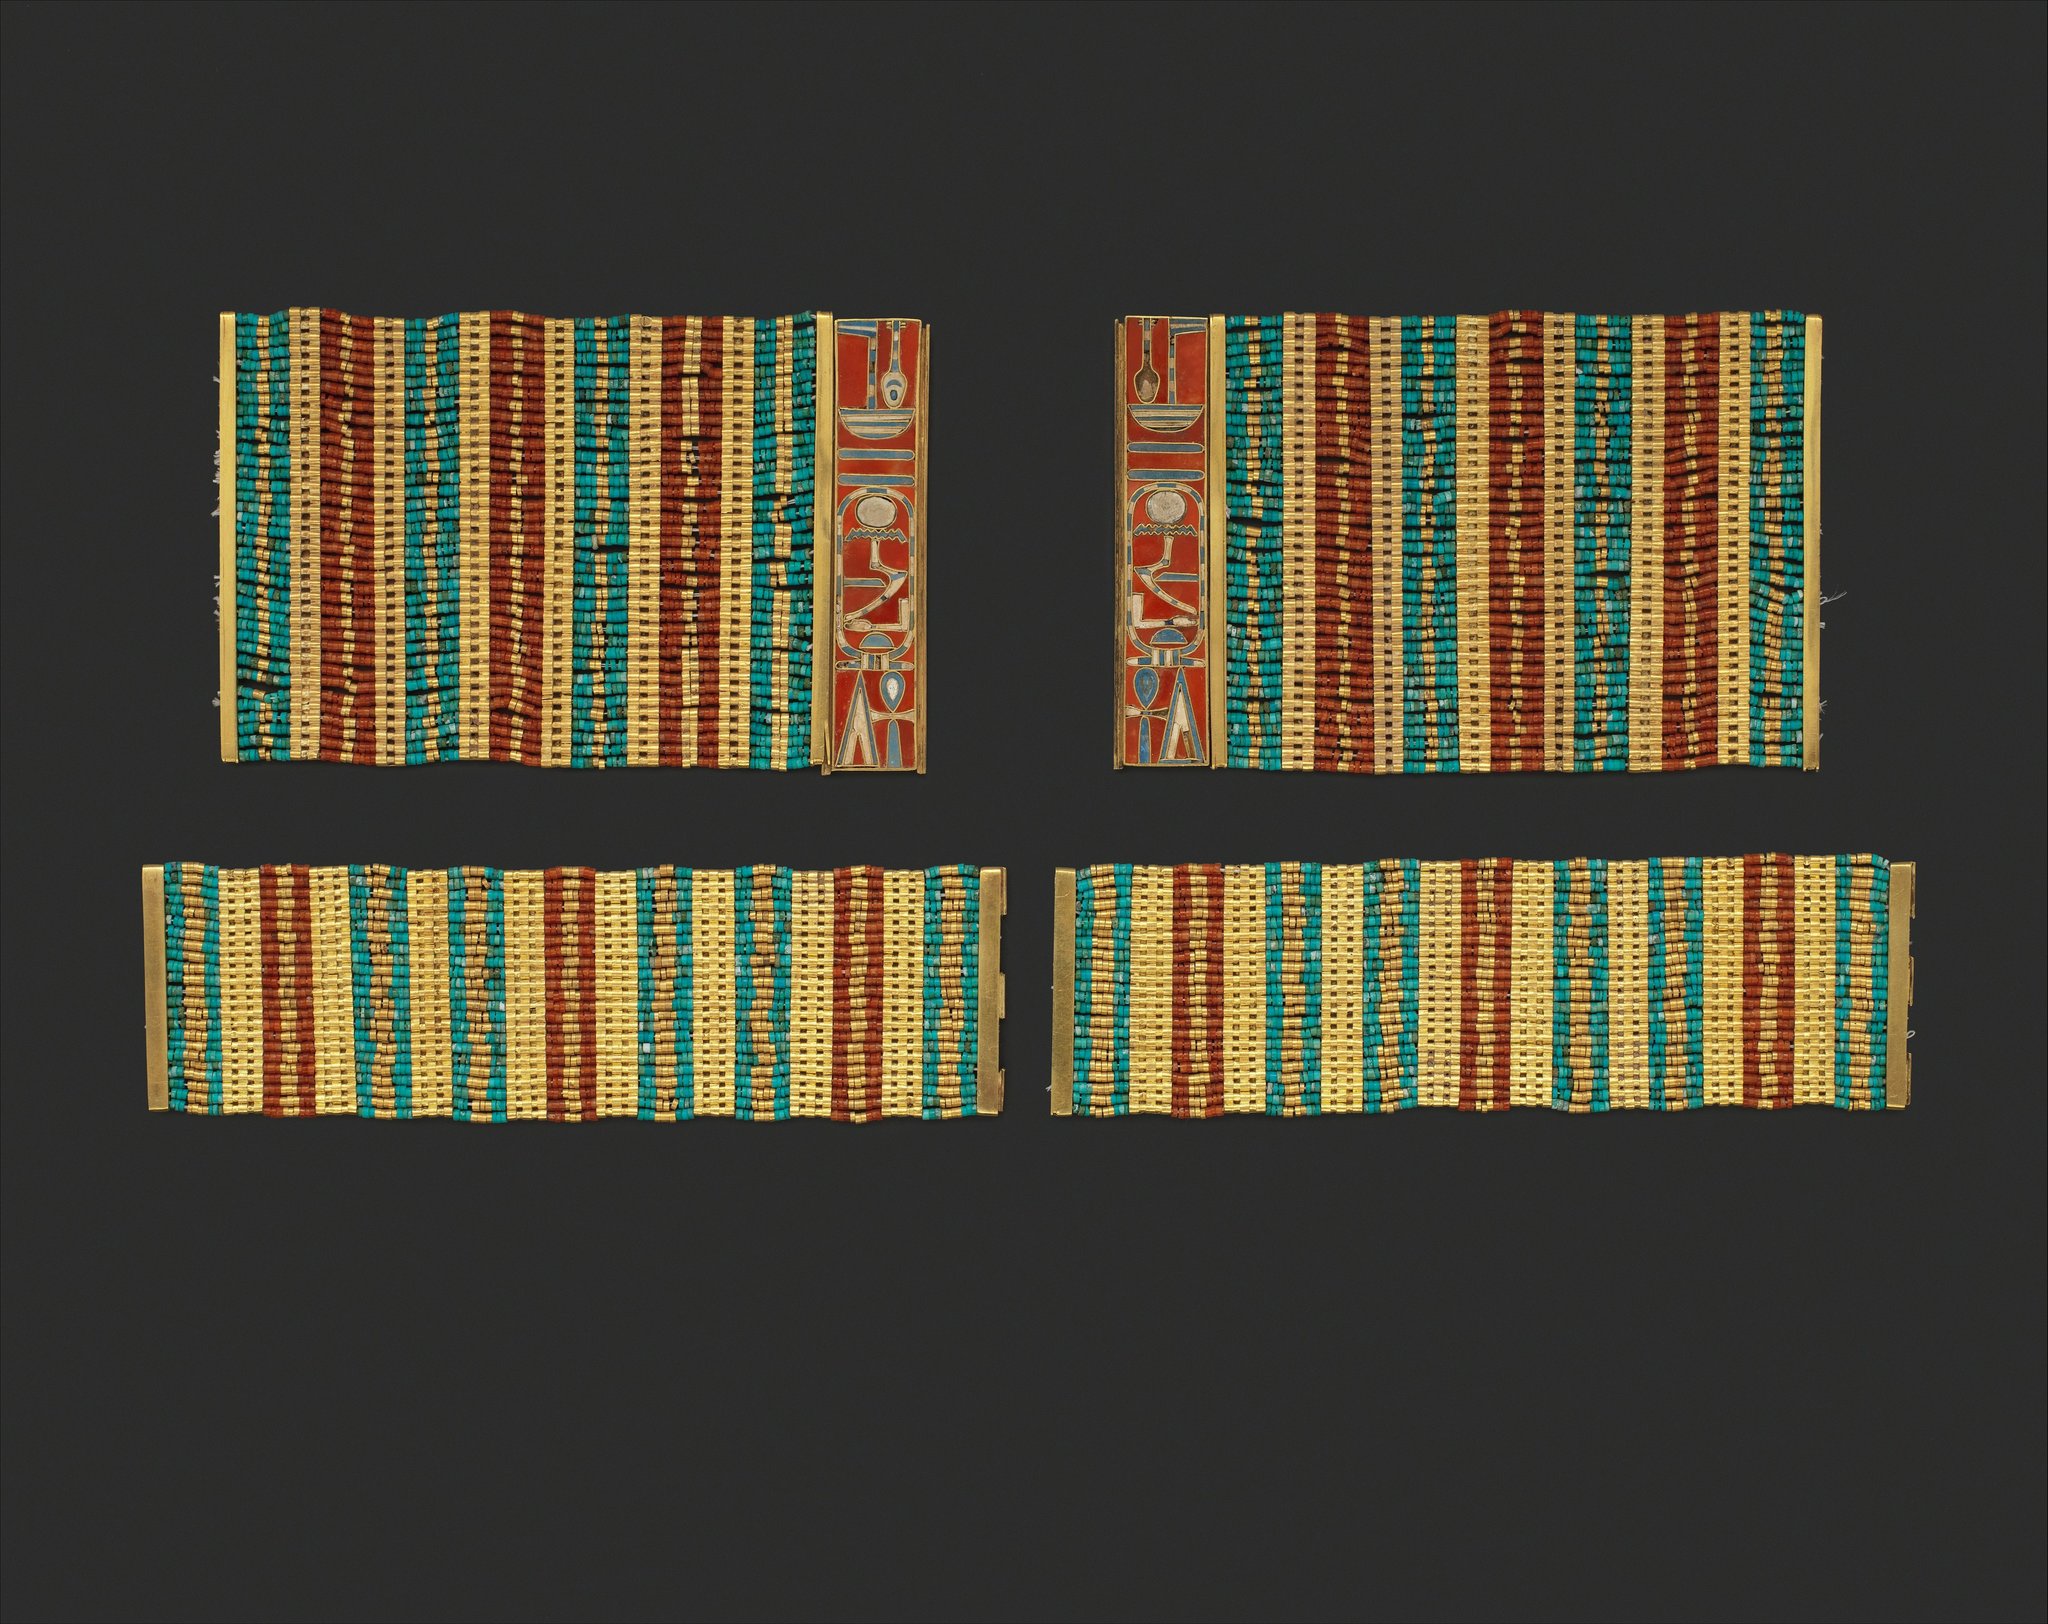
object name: anklet, sithathoryunet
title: Broad Anklet of Sithathoryunet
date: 1887-1813 BCE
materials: gemstone, gold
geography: egypt